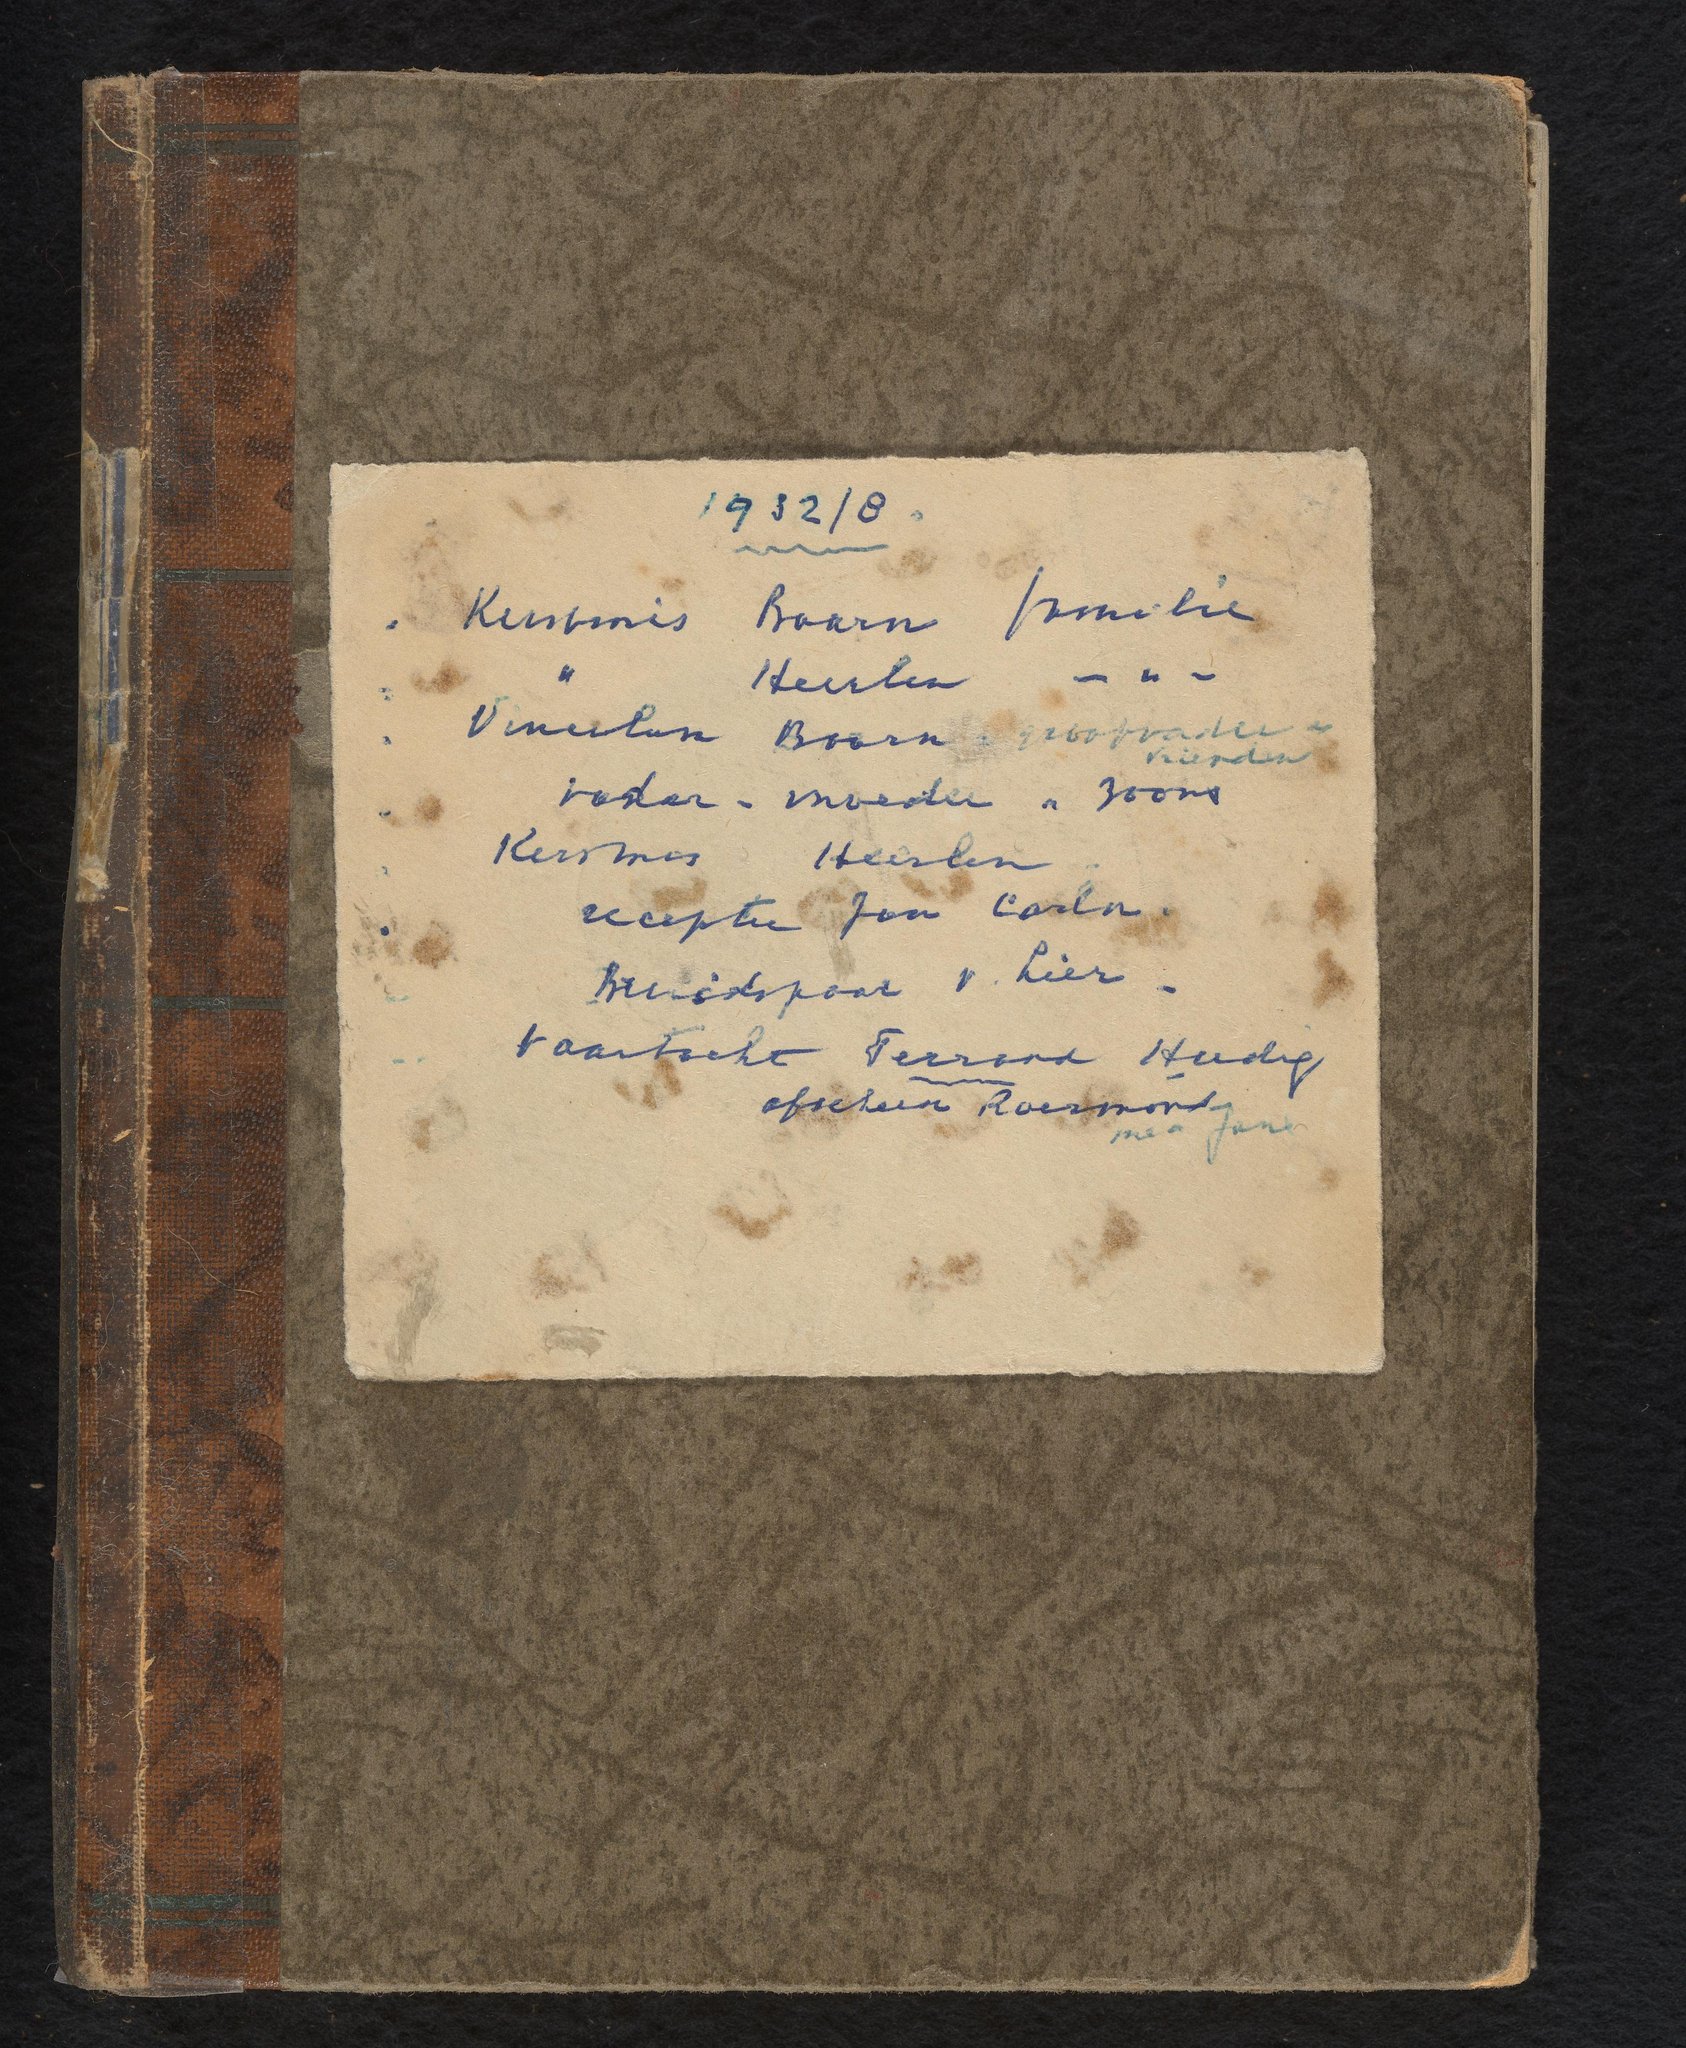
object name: photograph album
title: Fotoalbum met foto's van de familie van Dirk Hudig in Nederland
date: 1932-1957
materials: paper, cardboard, ink, pressure sensitive tape, textile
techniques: gelatin silver print, writing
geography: netherlands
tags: dirk hudig (1876-1973), civil marriage ceremony, family life at home, amsterdam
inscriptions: inscription: ‘1932/ Baarn/Heerlen/ 1933/8/ 1951/ [t]ocht Ferrand/ motorboot/ 1951’, inscription: ‘1932/8/ Kerstmis Baarn familie/ " Heerlen "/ Vinculum Baarn grootvader+vrienden/ vader-moeder-zoons/ Kerstmis Heerlen/ receptie Jan Carla/ Bruidspaar v. Lier/ Vaartocht Ferrand Hudig/ afscheid Roermond/ met Jan’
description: Insteekalbum met 87 foto's verdeeld over 55 pagina's, voorzien van handgeschreven bijschriften. Het album bevat foto's van de familie Hudig-Rotgans in Baarn en Heerlen, foto's van een professorengezelschap in Baarn, een huwelijk in Amsterdam in 1936 en van een boottocht bij Loosdrecht in 1951.